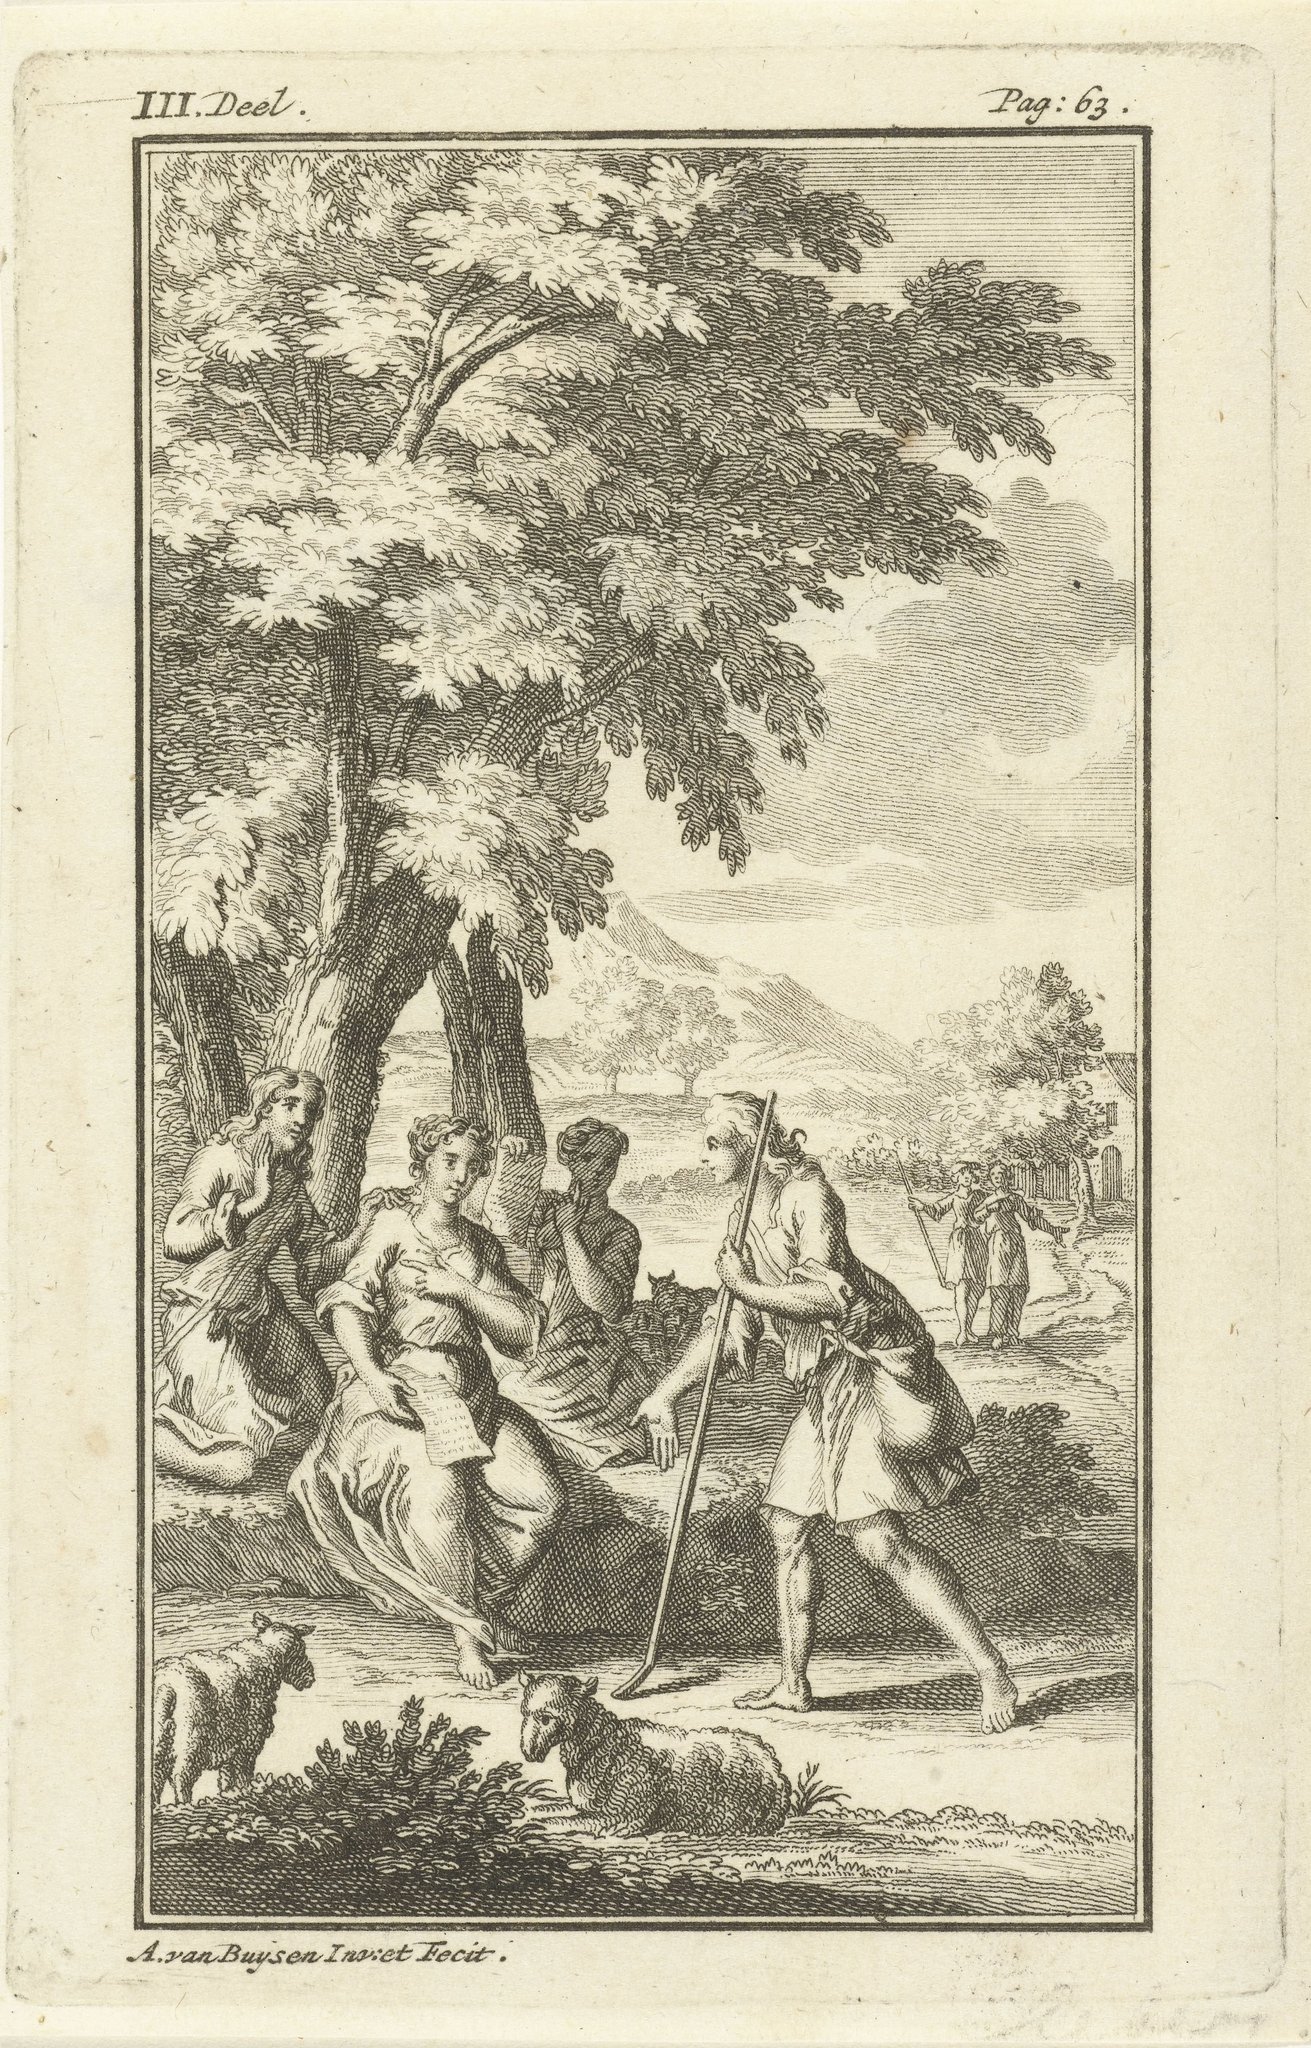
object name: book illustration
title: Ontmoeting van herder en herderin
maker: andries van buysen (sr.)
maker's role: print maker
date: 1723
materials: paper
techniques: engraving, etching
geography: amsterdam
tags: pastorals, arcadian scenes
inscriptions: collector's mark: Lugt 2228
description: Drie schaapherderinnen rusten uit onder een boom. Ze lezen brieven. Een jonge schaapherder loopt langs de weg en maakt een praatje met hun.